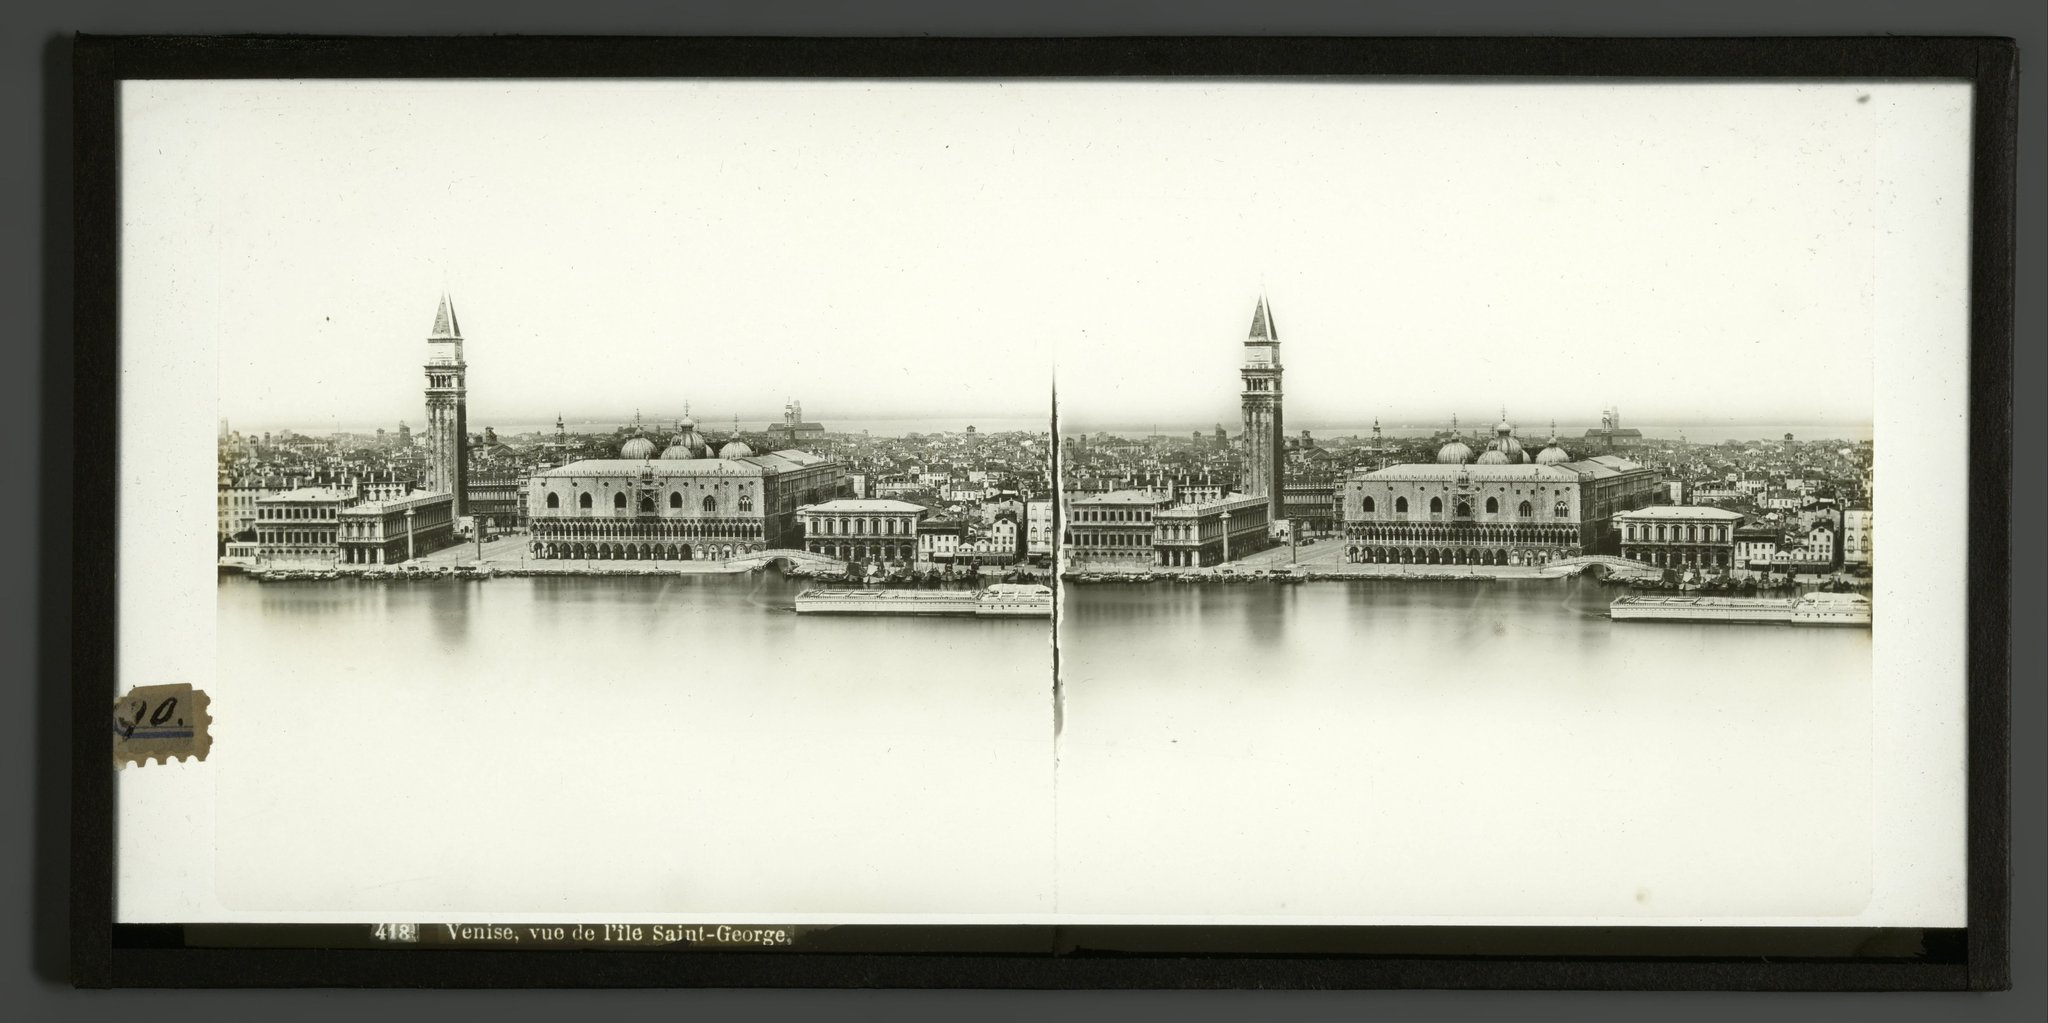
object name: stereoscopic photograph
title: Venise, vue de l'ile Saint-George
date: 1860-1870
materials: glass, paper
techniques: slide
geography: venice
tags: island, prospect of city, town panorama, silhouette of city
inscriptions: number: ‘90.’, number: ‘4118’